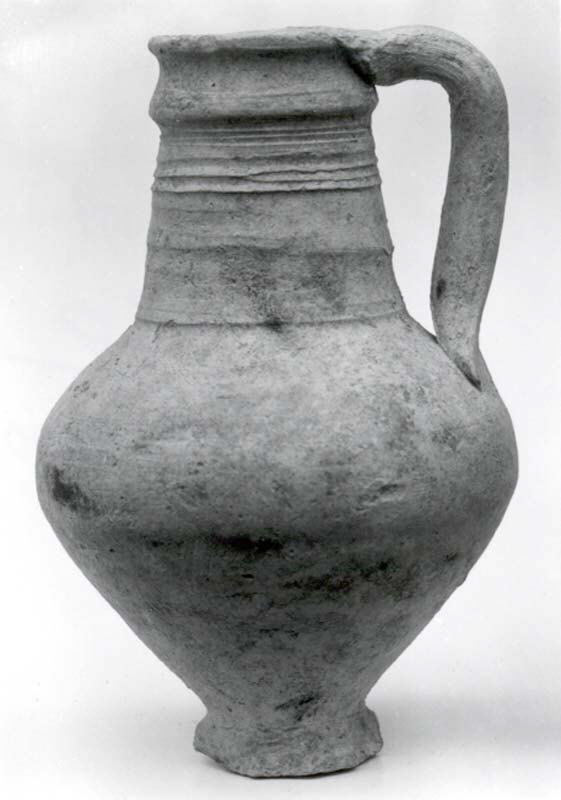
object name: jug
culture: sasanian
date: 201-700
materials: ceramic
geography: mesopotamia